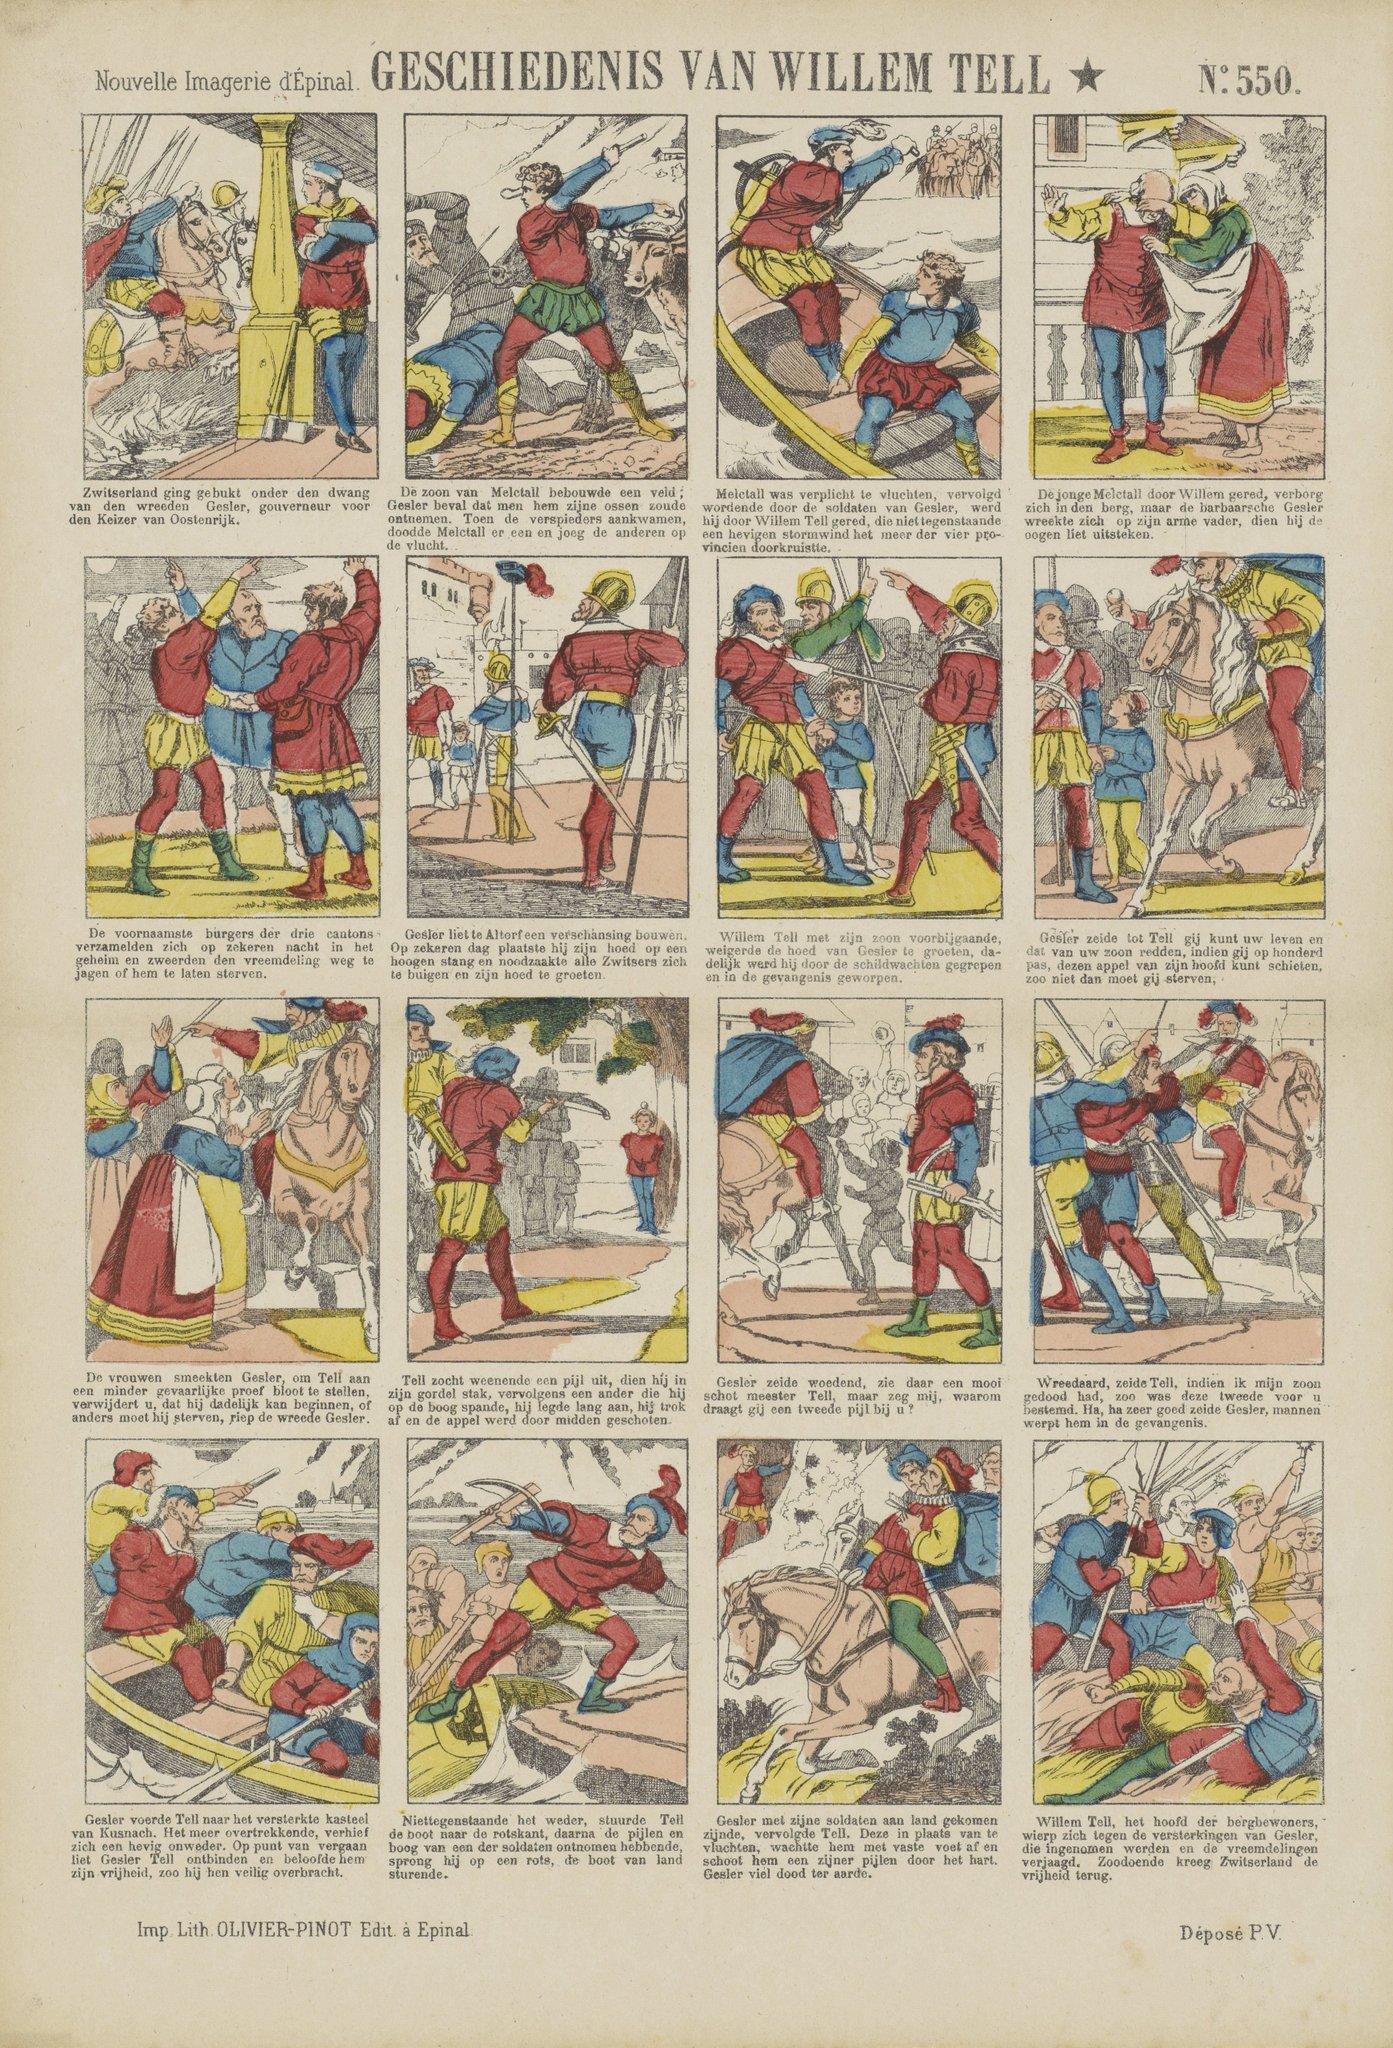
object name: popular print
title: Geschiedenis van Willem Tell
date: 1874-1888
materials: paper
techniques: colour, letterpress printing, lithograph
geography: europe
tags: william tell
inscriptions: collector's mark: Lugt 2760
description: Blad met 16 voorstellingen uit het leven van Willem Tell. Onder elke voorstelling een onderschrift in het Nederlands. Genummerd rechtsboven: No. 550.